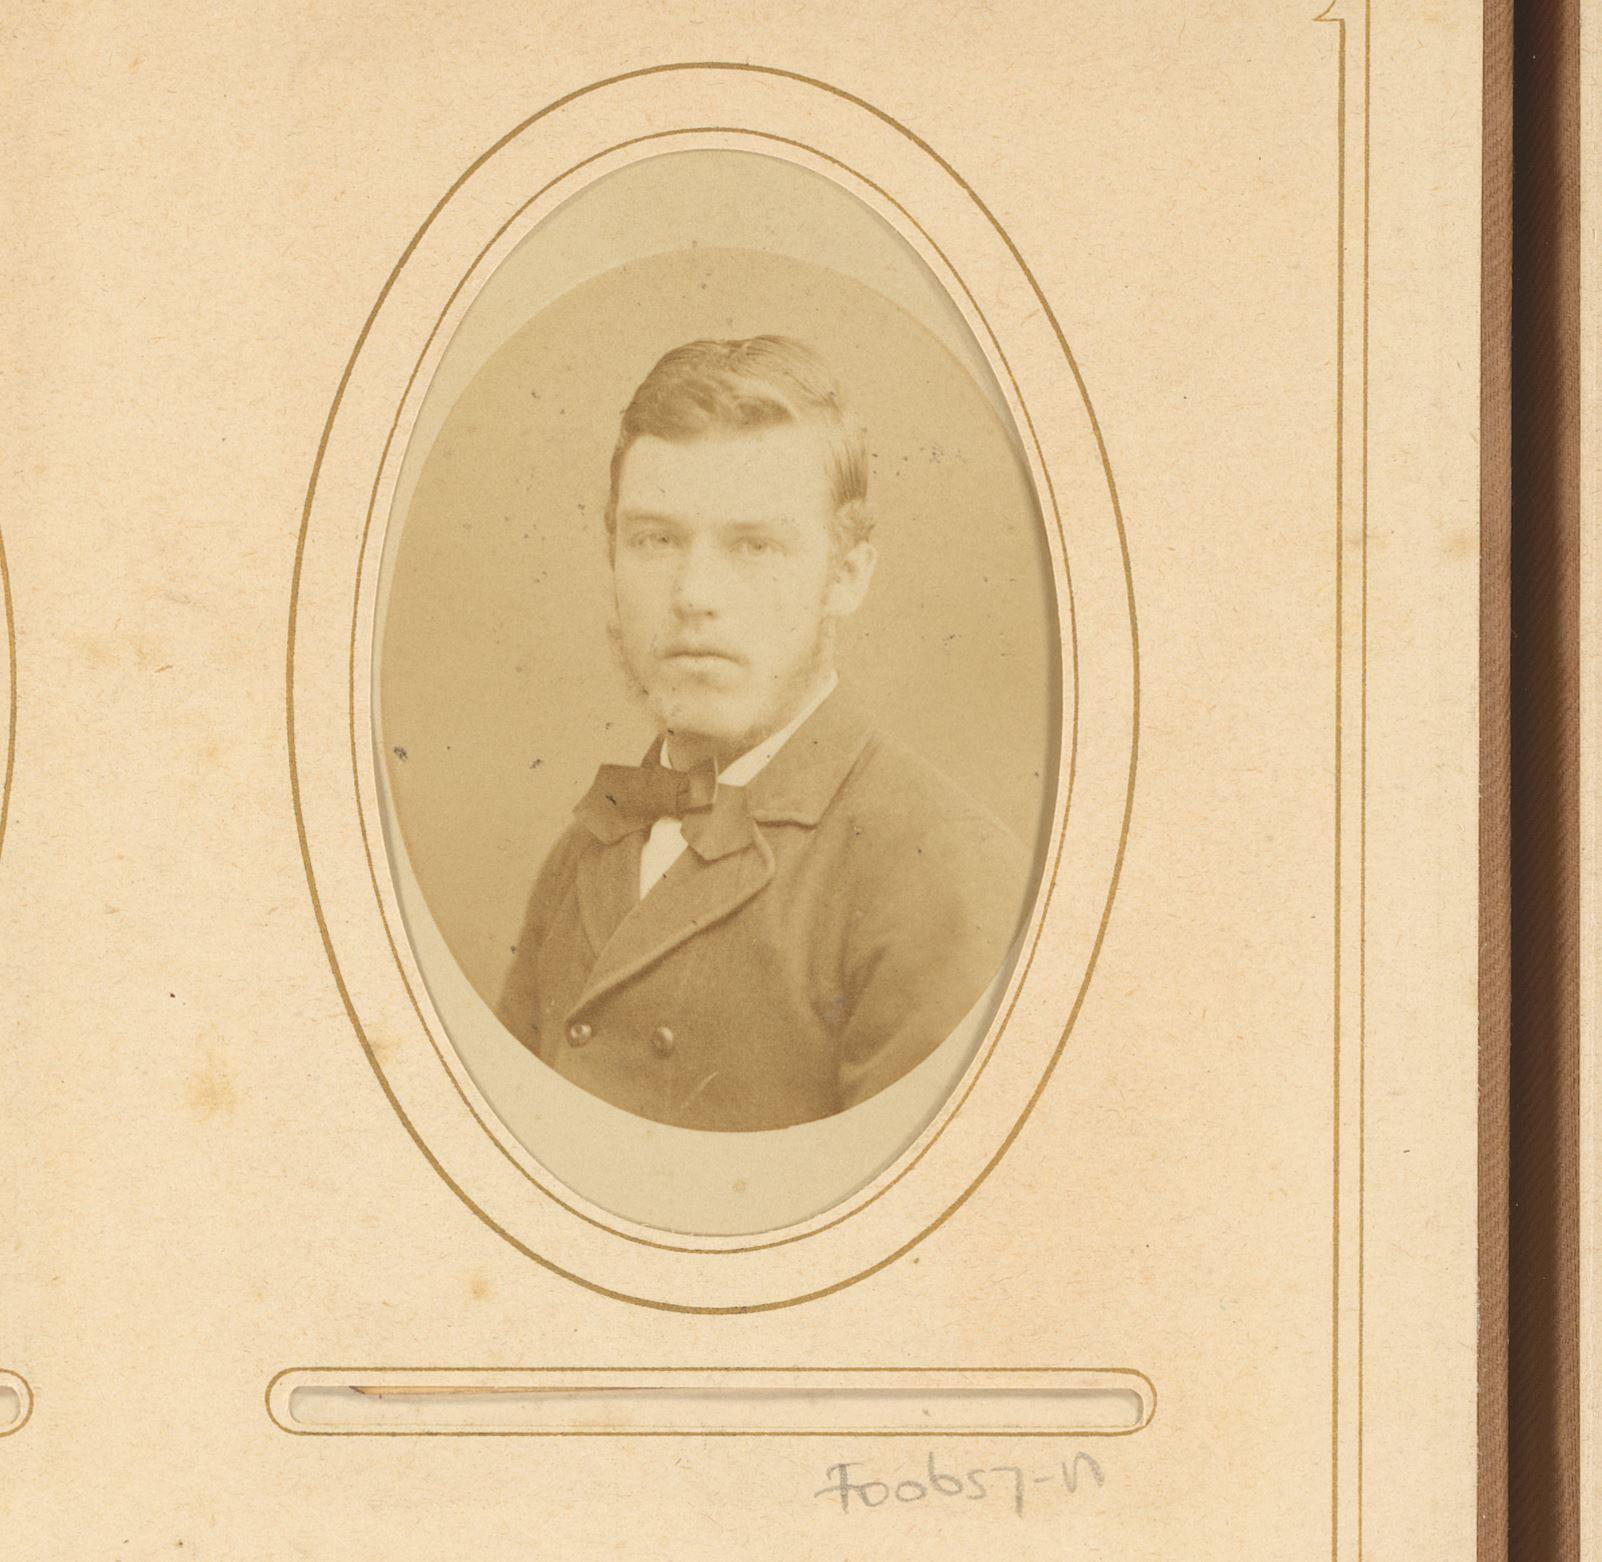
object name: album leaf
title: Portret van een man met vlinderdas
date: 1876-1889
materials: cardboard, photographic support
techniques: albumen print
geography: brisbane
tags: historical persons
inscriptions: inscription: ‘Artist/ Photographers/ Mathewson & Co/ Brisbane/ A life size enlargement may be had/ of this picture at a very low price./ Orders by post receive our best attention.’